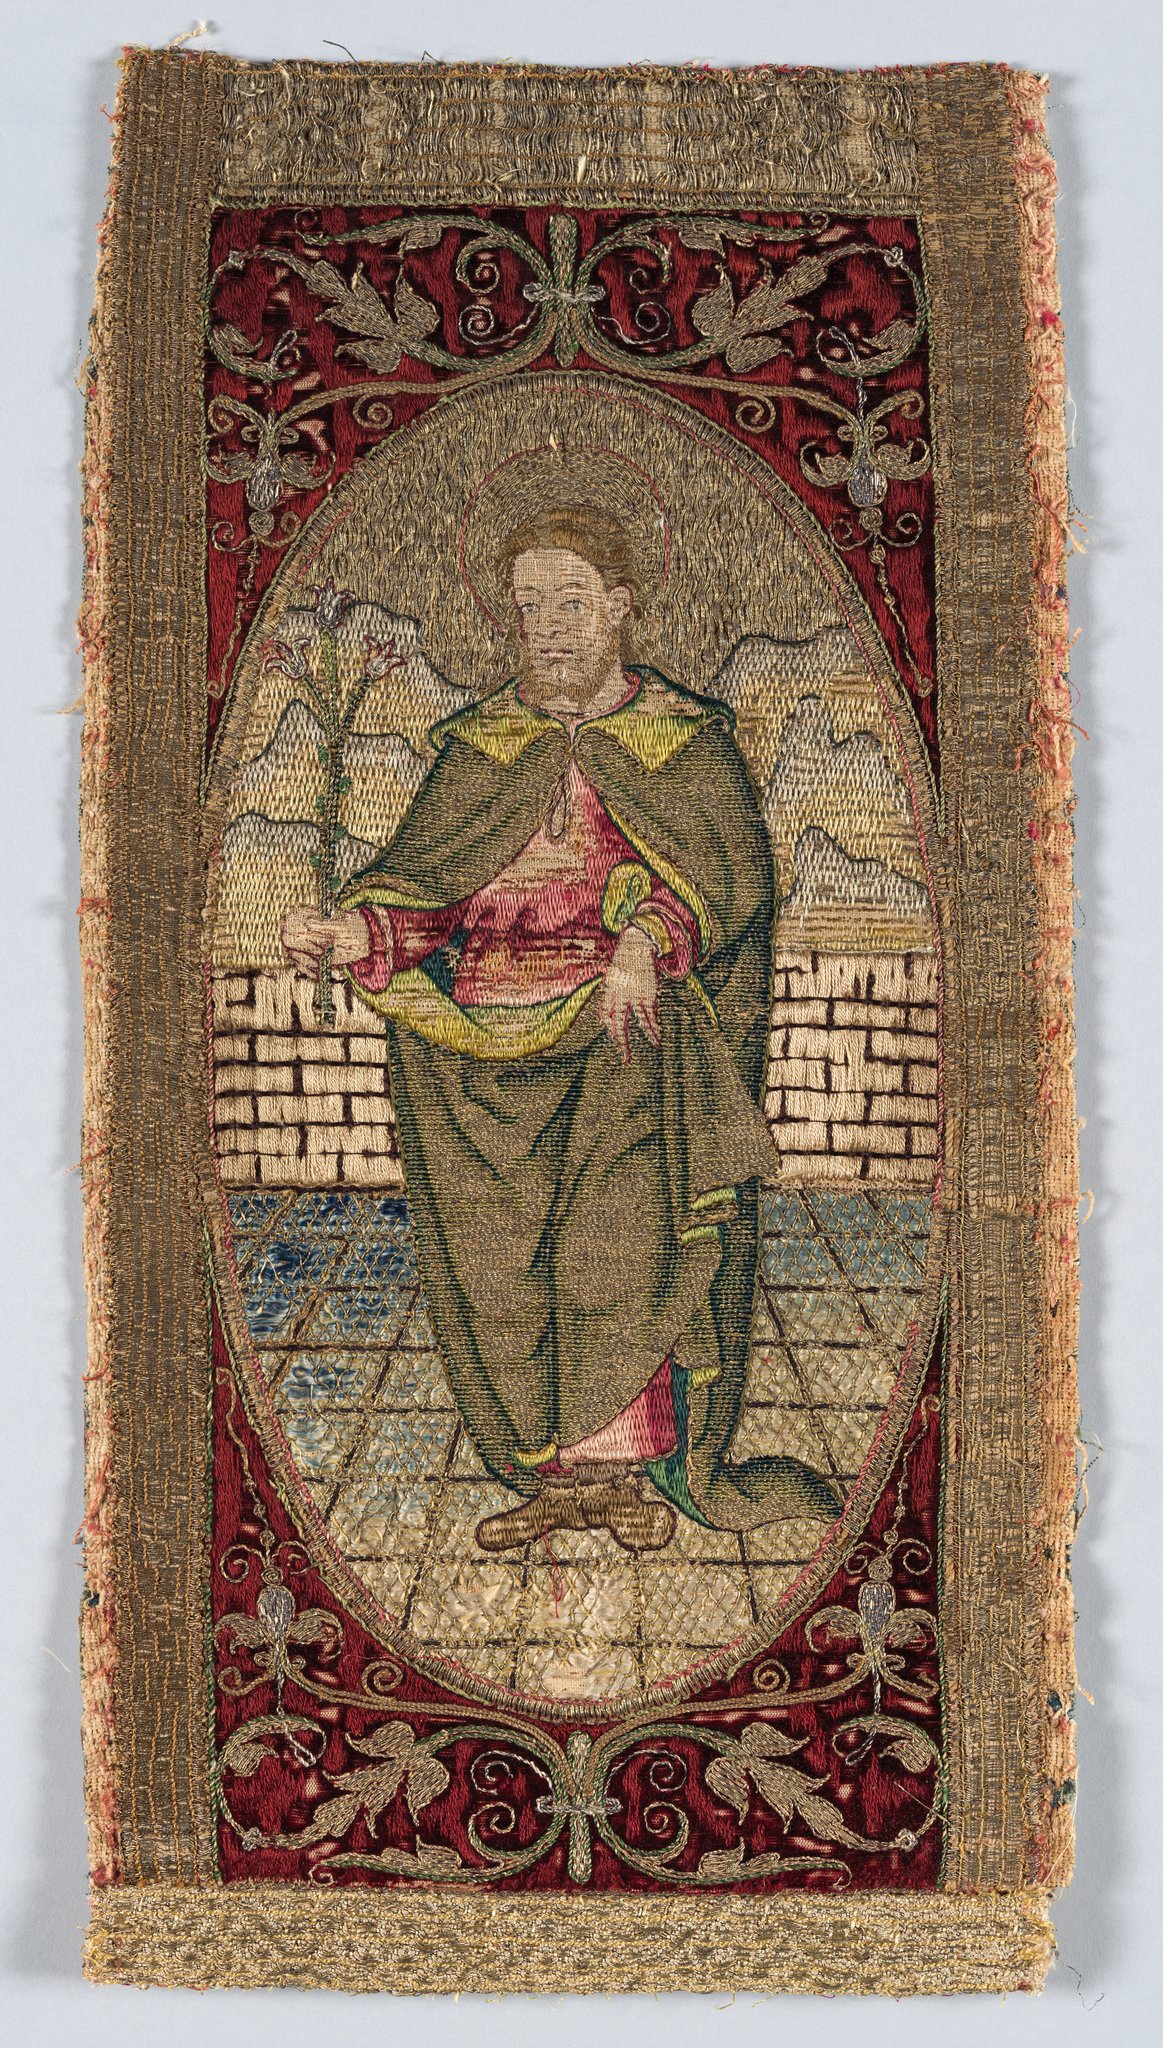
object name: cushion made from orphrey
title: Orphrey section made into cushion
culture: italian or spanish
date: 1551-1600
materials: linen, metal, silk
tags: men